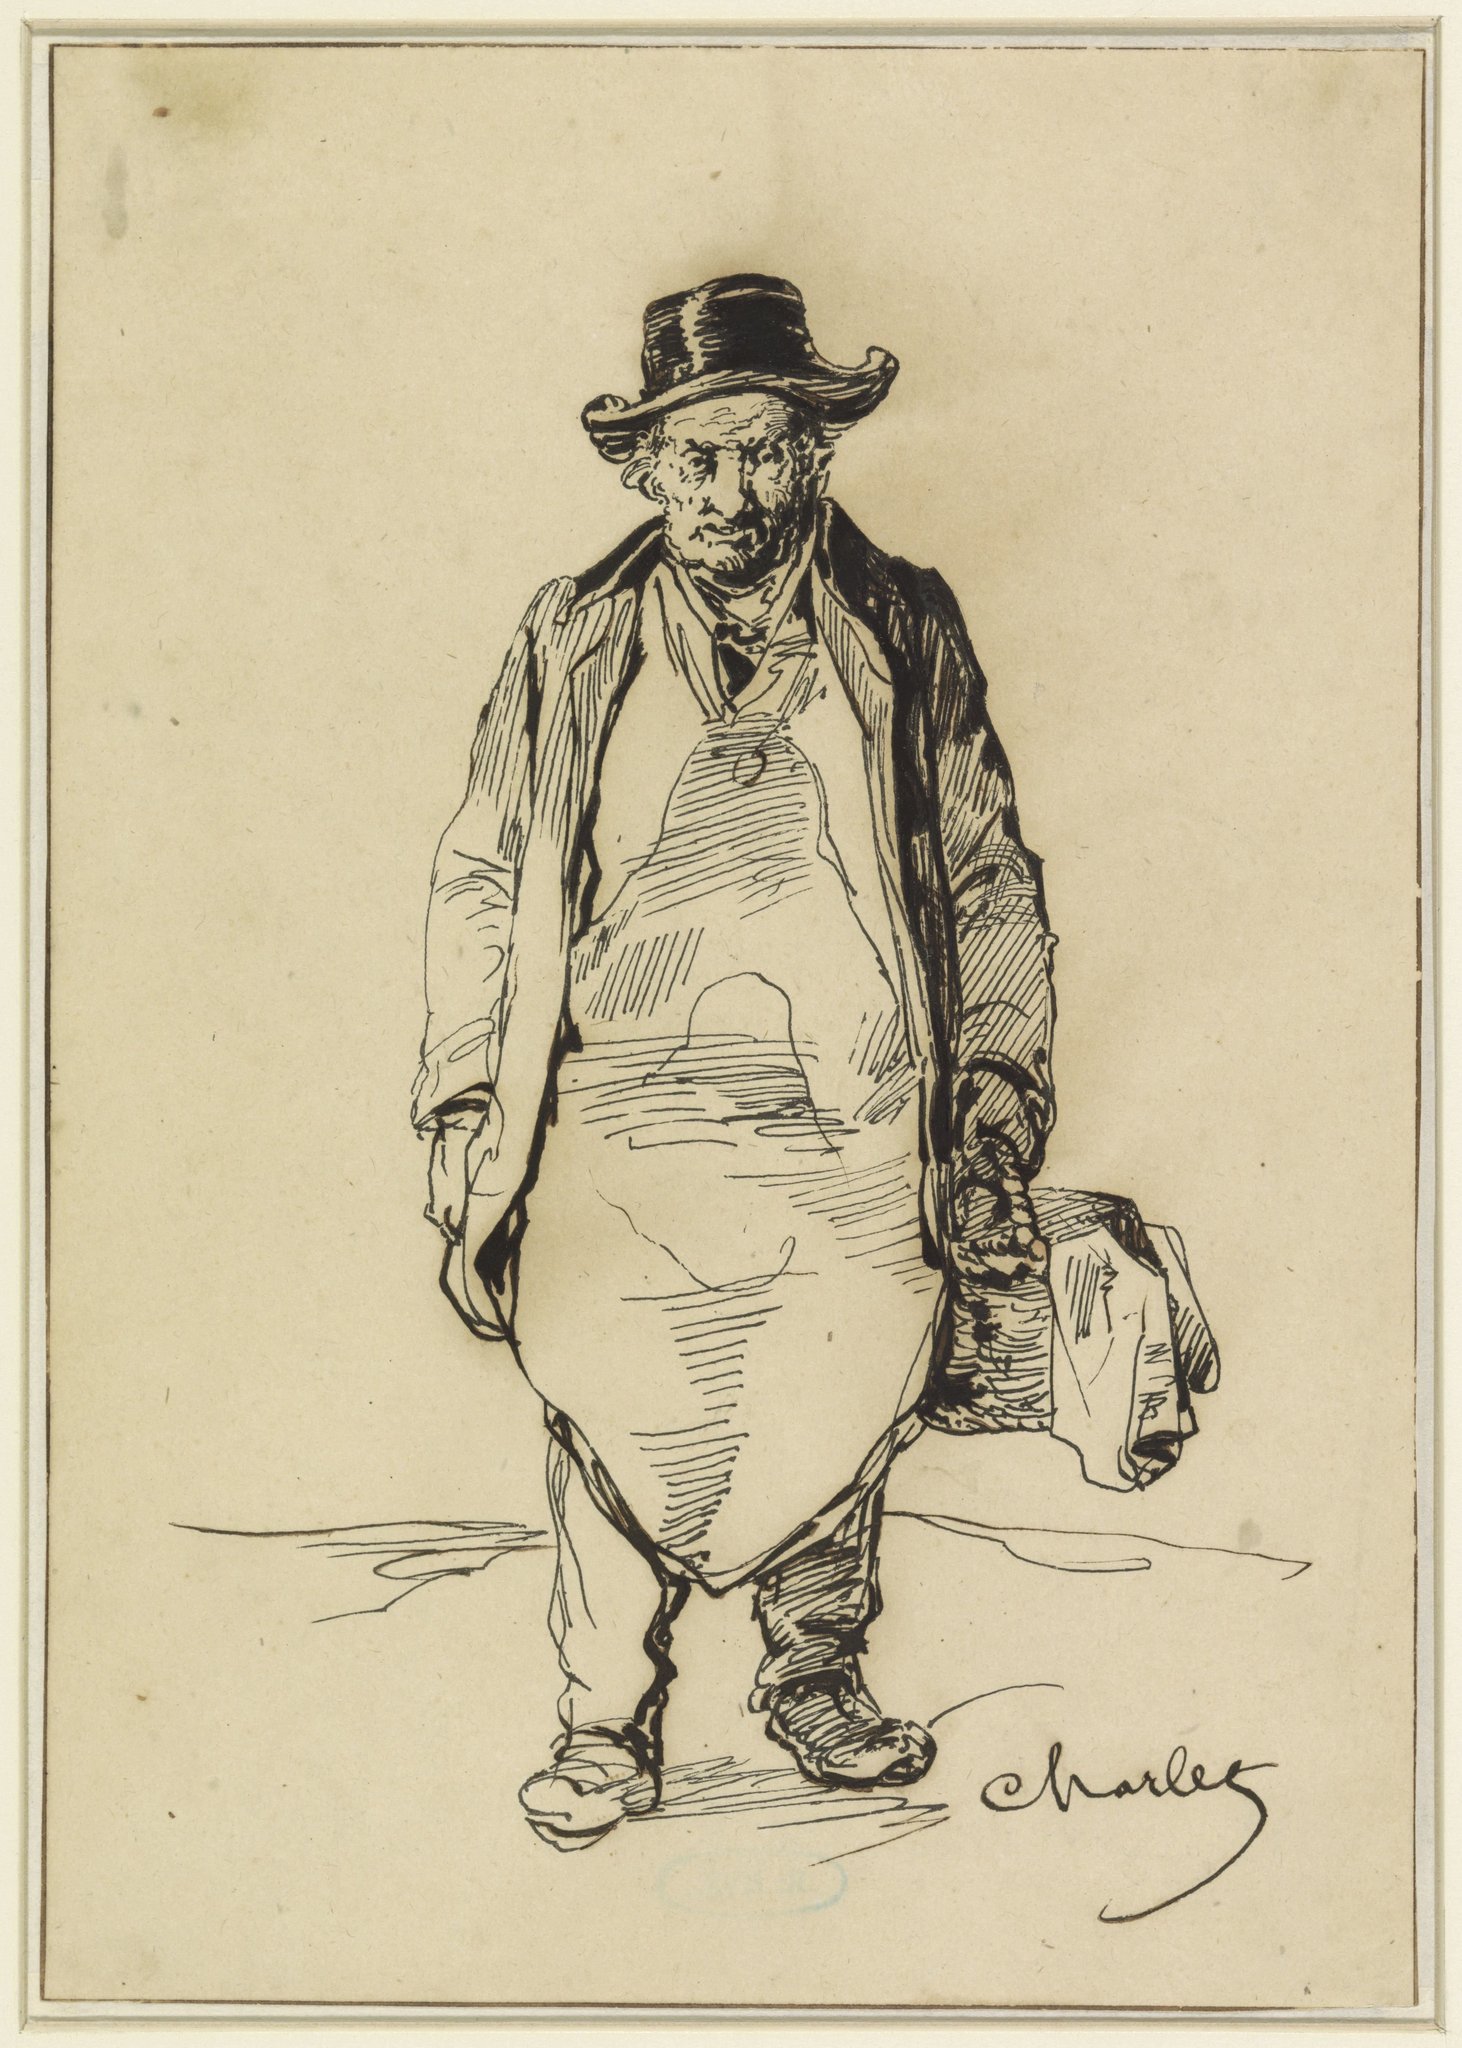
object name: drawing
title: Staande man met schort, in de linkerhand een mand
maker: nicolas toussaint charlet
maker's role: draughtsman, painter, print maker, printer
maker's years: 1792-1845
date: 1802-1845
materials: ink, paper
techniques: pen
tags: standing figure, persons engaged in trade and commerce